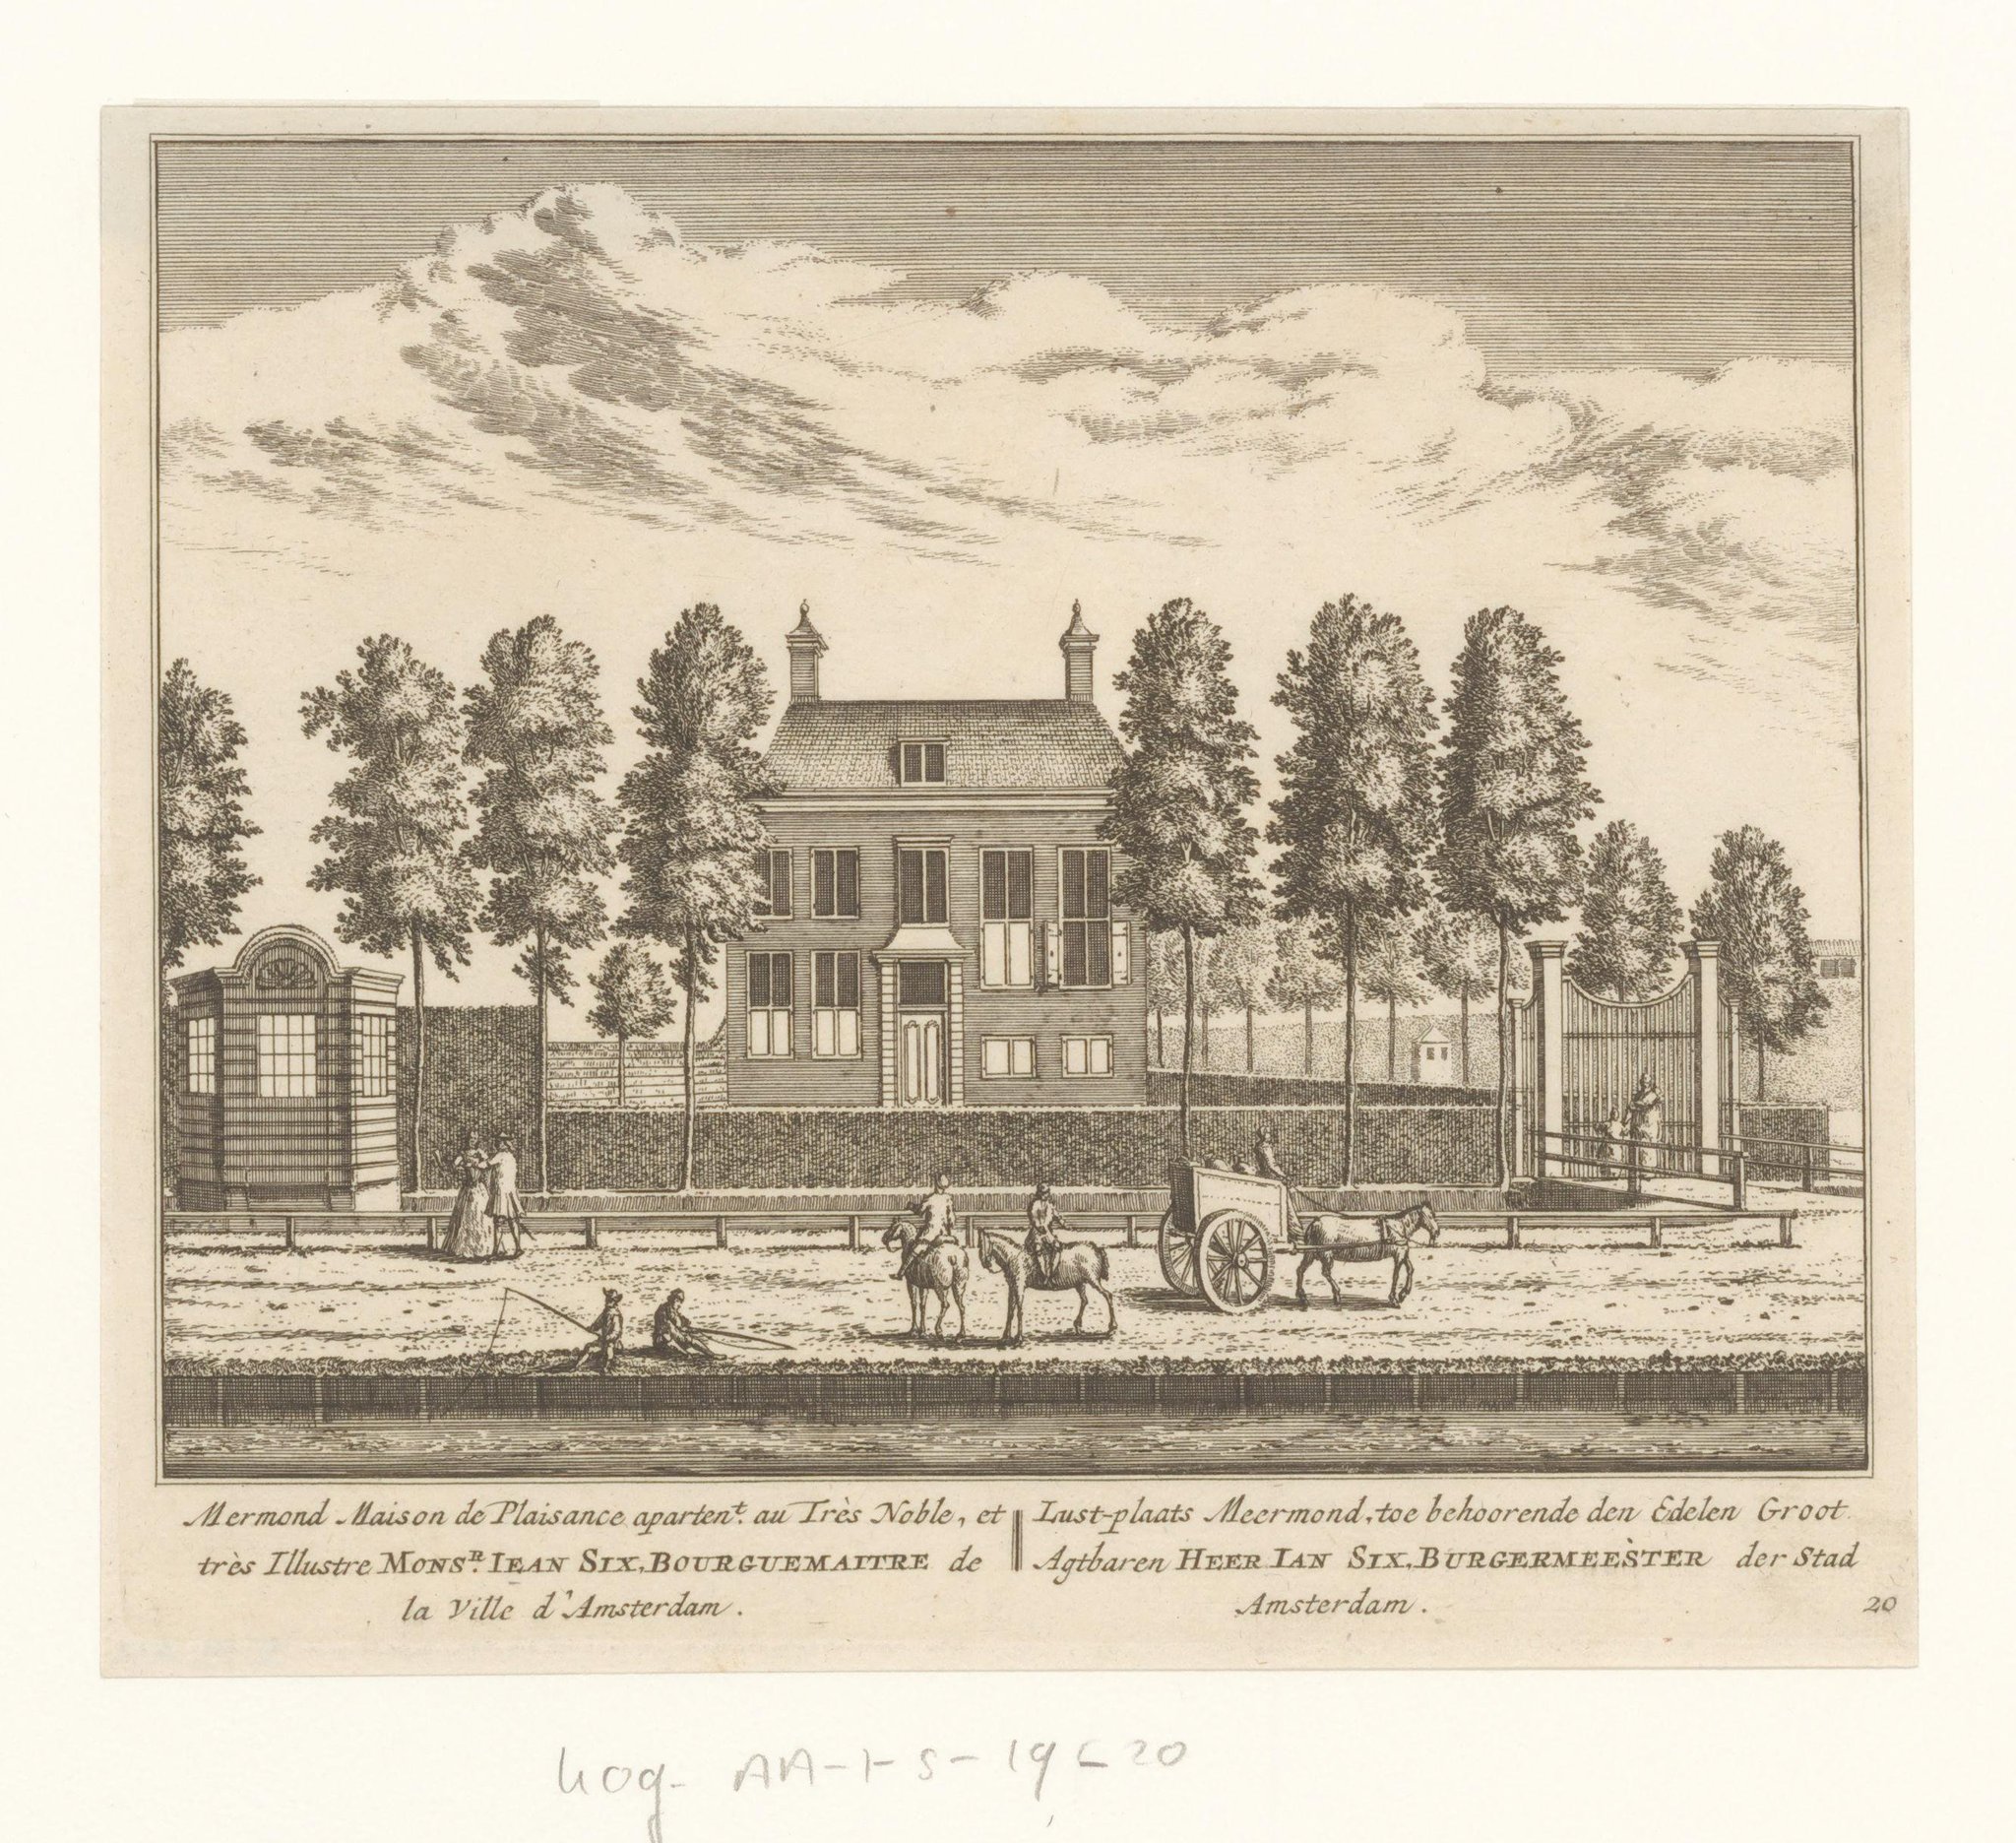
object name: print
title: Hollands Arcadia, of de vermaarde rivier den Amstel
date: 1730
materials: paper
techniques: etching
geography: amsterdam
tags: city-view in general; 'veduta', river, rural housing, e.g. country-house, villa, cottage, angling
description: Prent waarschijnlijk uit: Tijsens, Gijsbert. Hollands Arcadia, of de vermaarde rivier den Amstel (...) naar 't léven getekend en in 't ligt gebragt door Abraham Rademaker (...). Amsterdam: Leonardus Schenk, 1730.